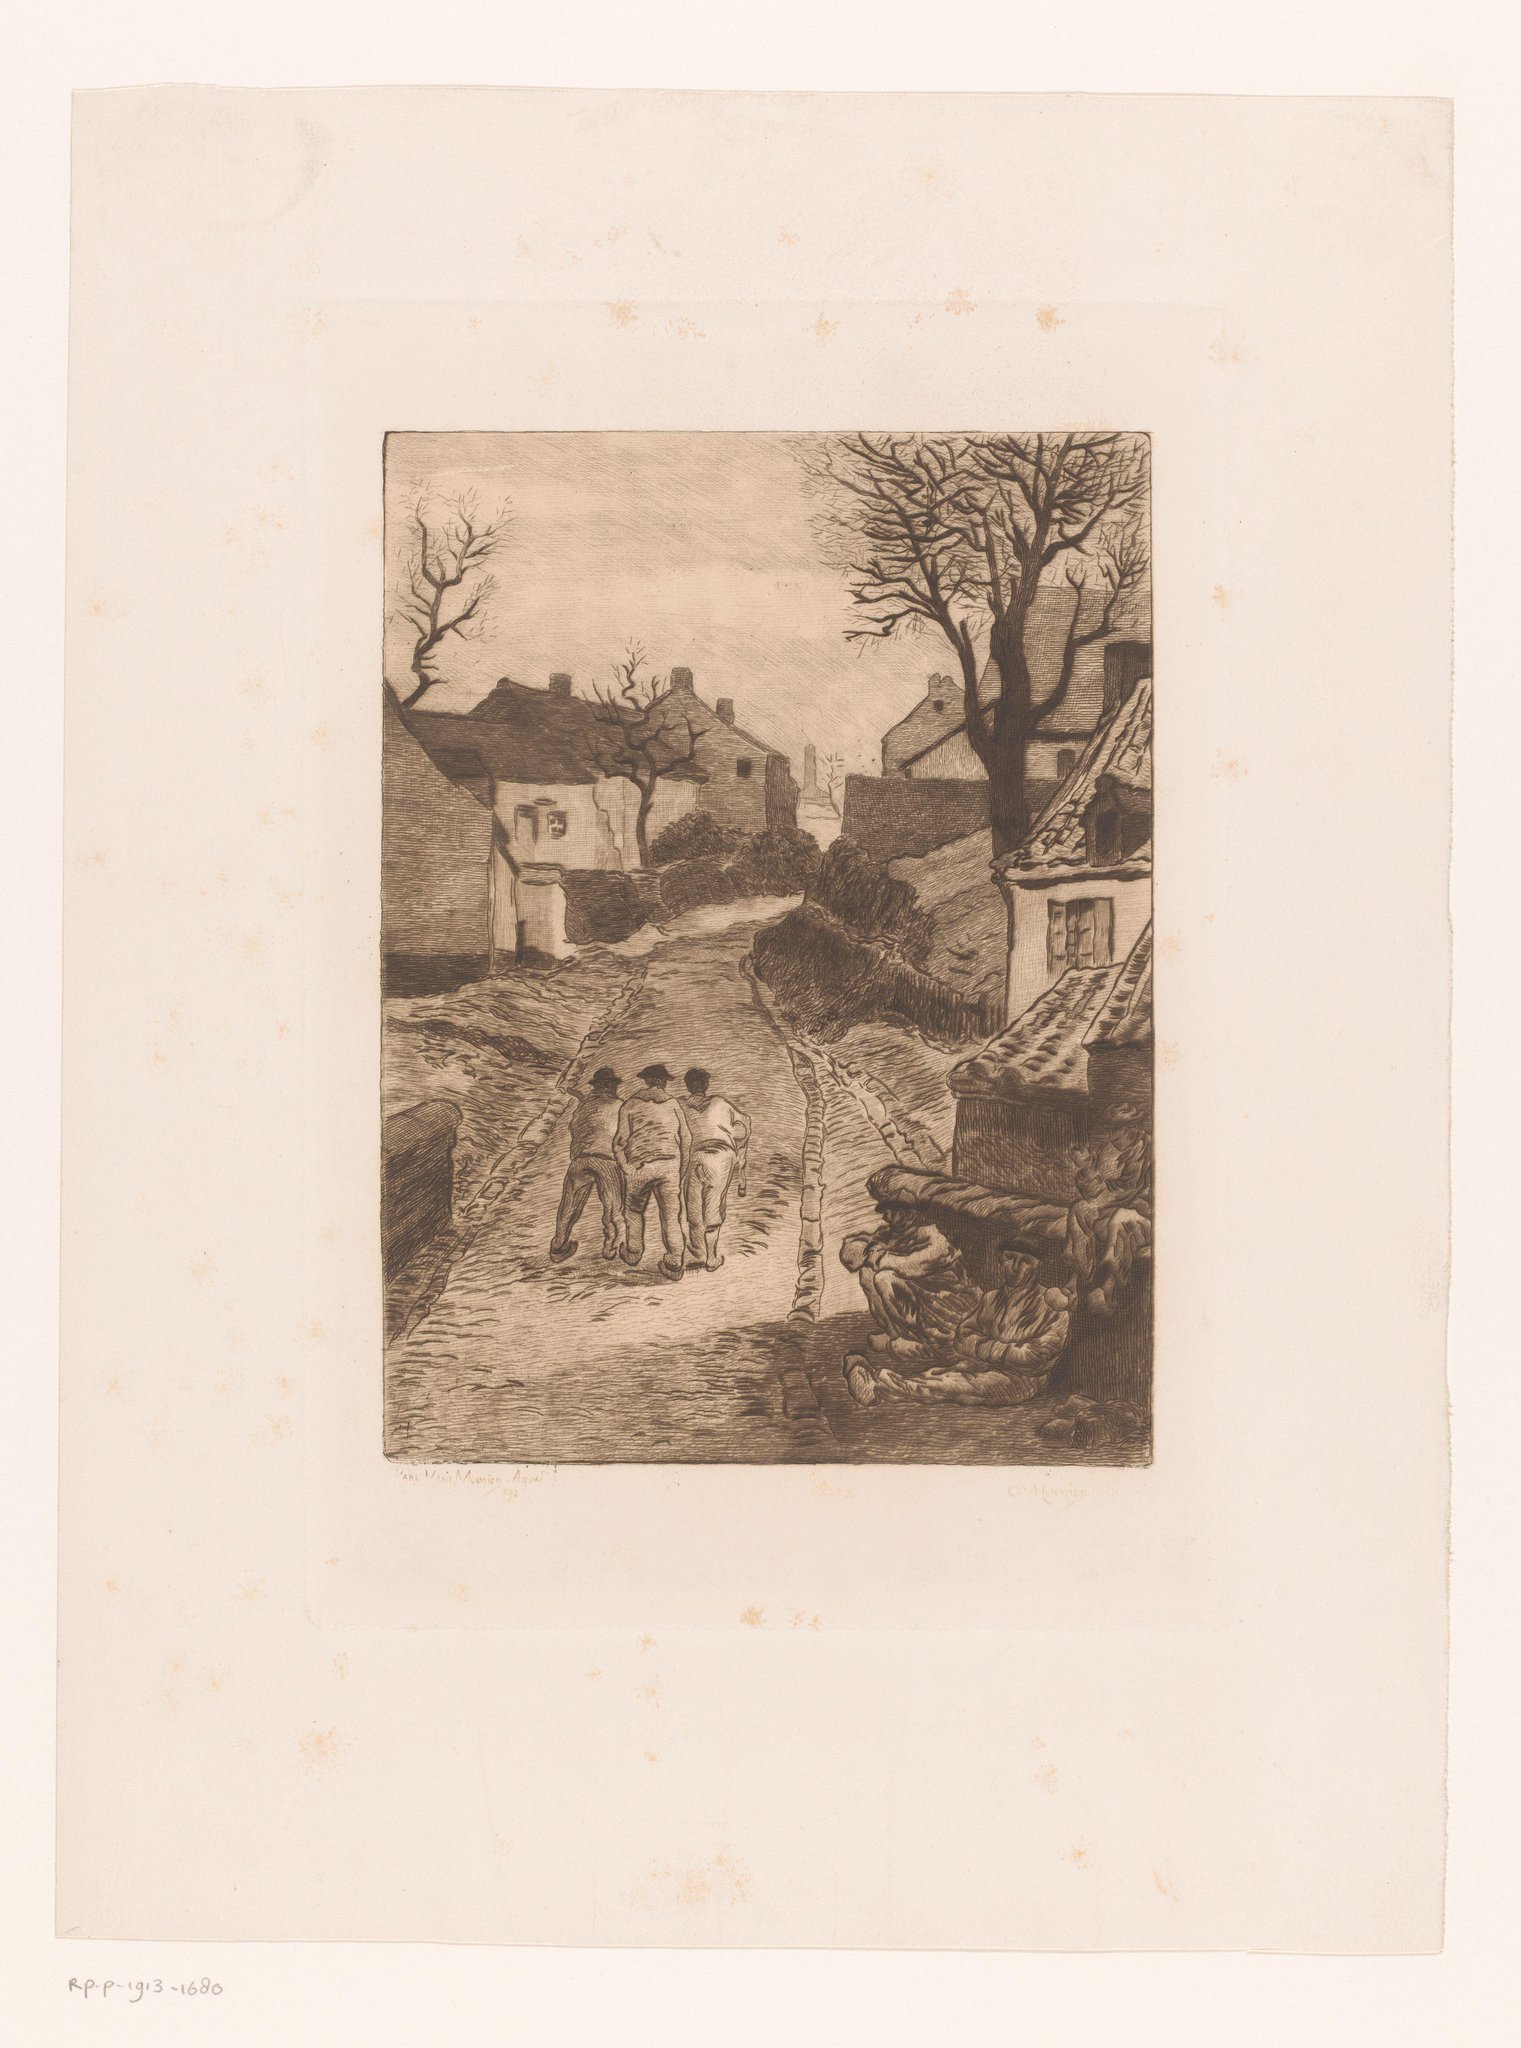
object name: print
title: Drie mannen lopen op een weg in een mijnwerkersdorp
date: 1892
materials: paper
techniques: drypoint, etching, intaglio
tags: miner, labourers returning home, village, public road in village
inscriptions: collector's mark: Lugt 2228